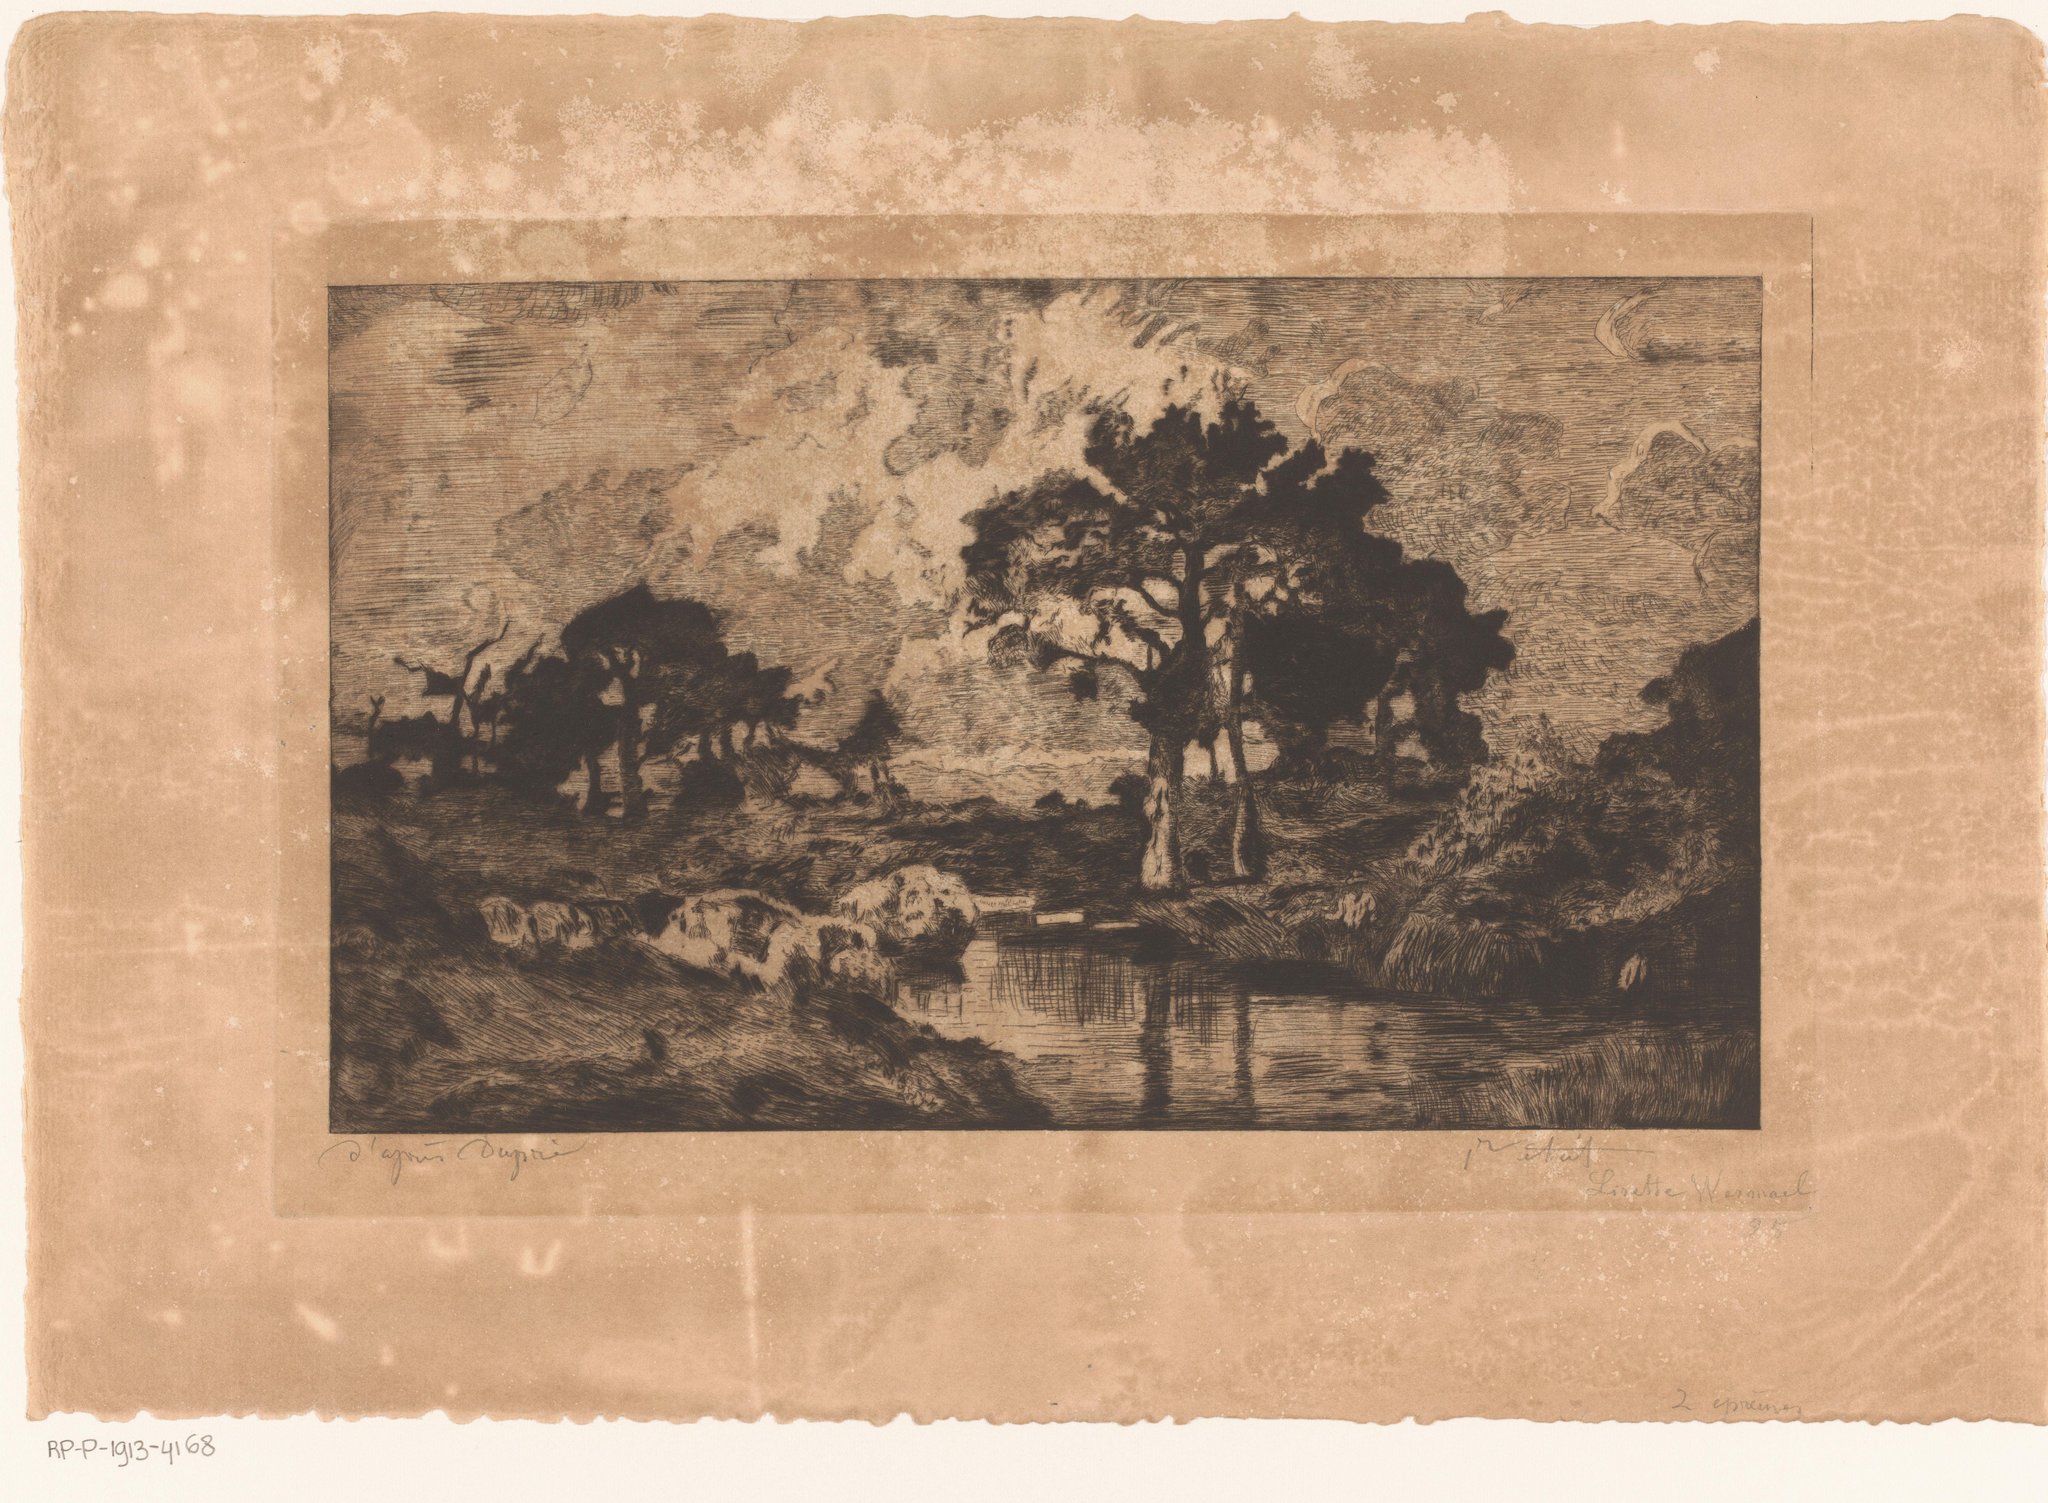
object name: print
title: Landschap met bomen langs water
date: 1895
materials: paper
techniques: drypoint, etching, retroussage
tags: landscapes with waters, waterscapes, seascapes (in the temperate zone)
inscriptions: annotation: ‘2 epréuves’, collector's mark: Lugt 2228